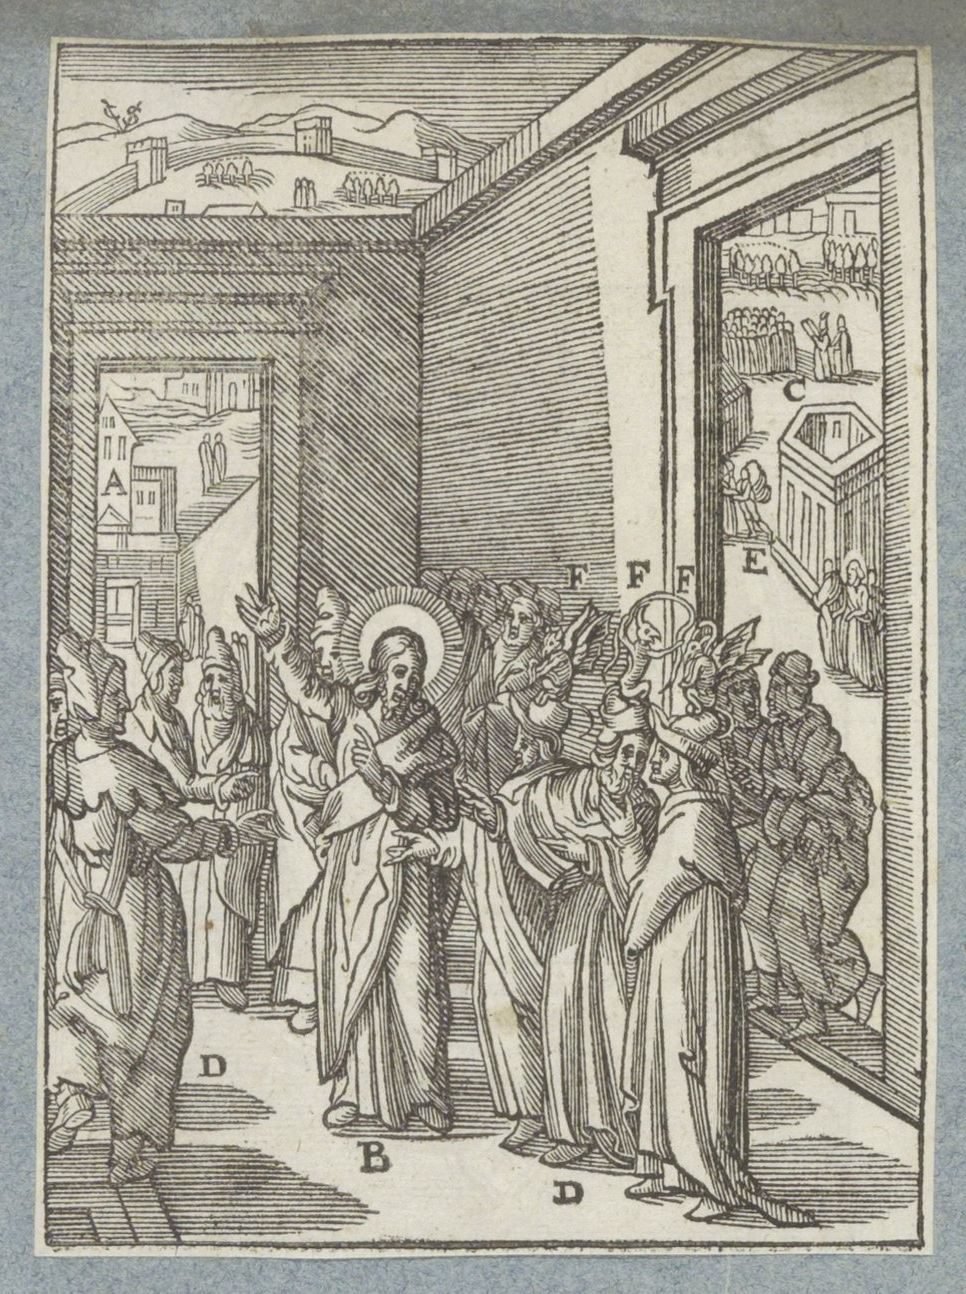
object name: book illustration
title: Preek van Christus in de tempel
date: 1629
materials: paper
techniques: letterpress printing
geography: amsterdam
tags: christ is teaching in the temple in the middle of the feast of tabernacles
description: De prent is afkomstig uit een van de uitgaven van P.J. Paets uit Amsterdam. Ze wordt voor het eerst gebruikt in: Der Zielen Lust-hof. Leuven, I.Jacbosz voor P.J. Paets [= Amsterdam, P.J. Paets], 1629. De voorstelling is gekopieerd naar een prent van Antonie II Wierix voor: Nadal, Jerónimo. Evangelicae Historiae Imagines. Antwerpen, M. Nutius, 1593.